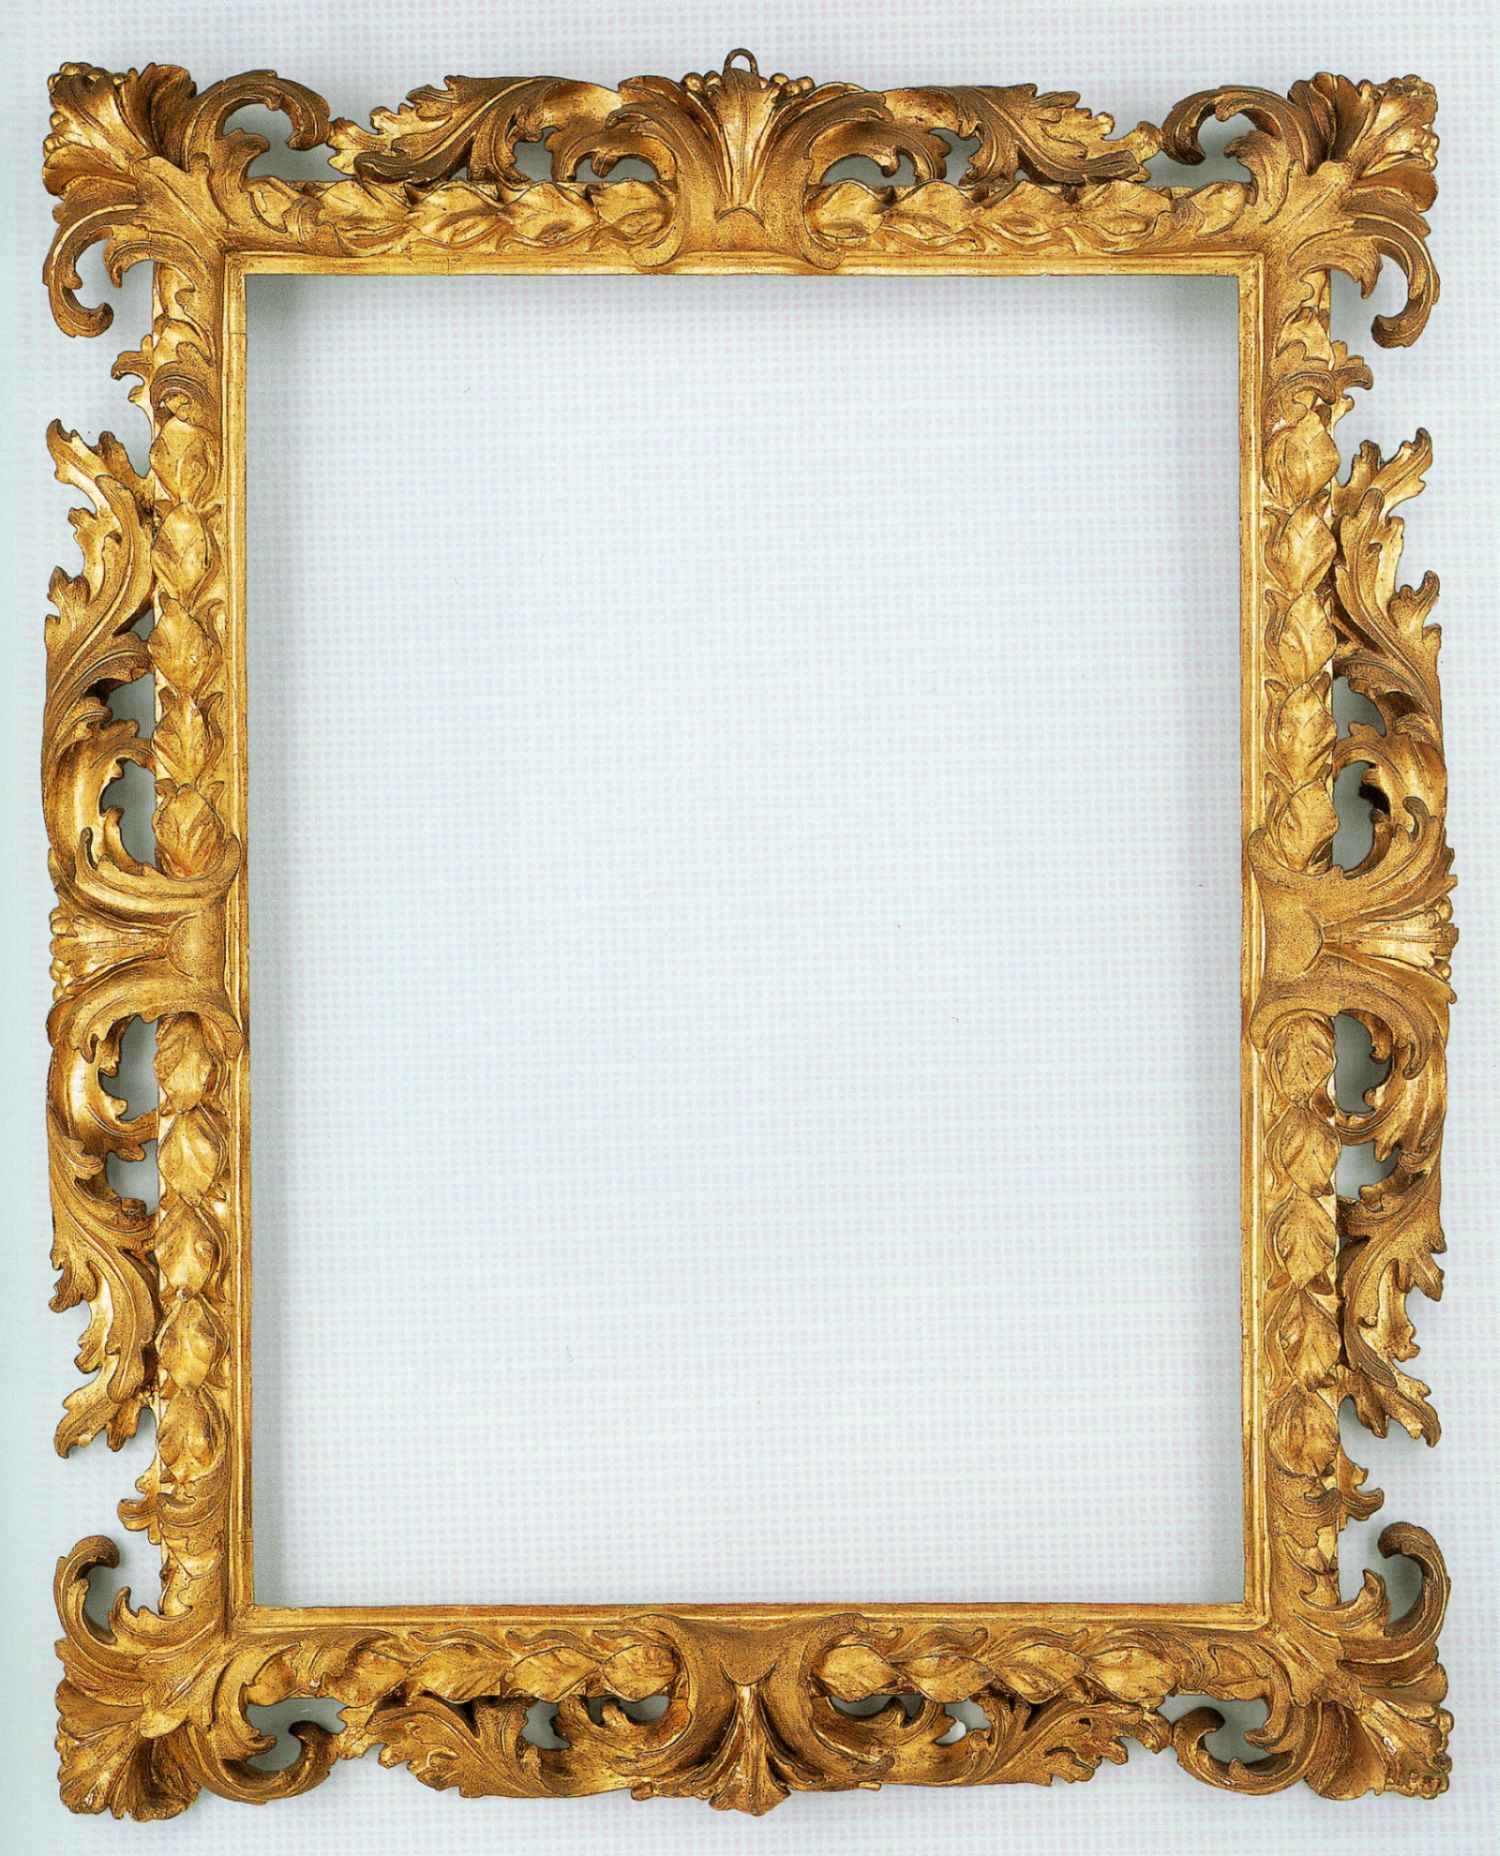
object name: frame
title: Pierced acanthus-leaf frame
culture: italian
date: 1640